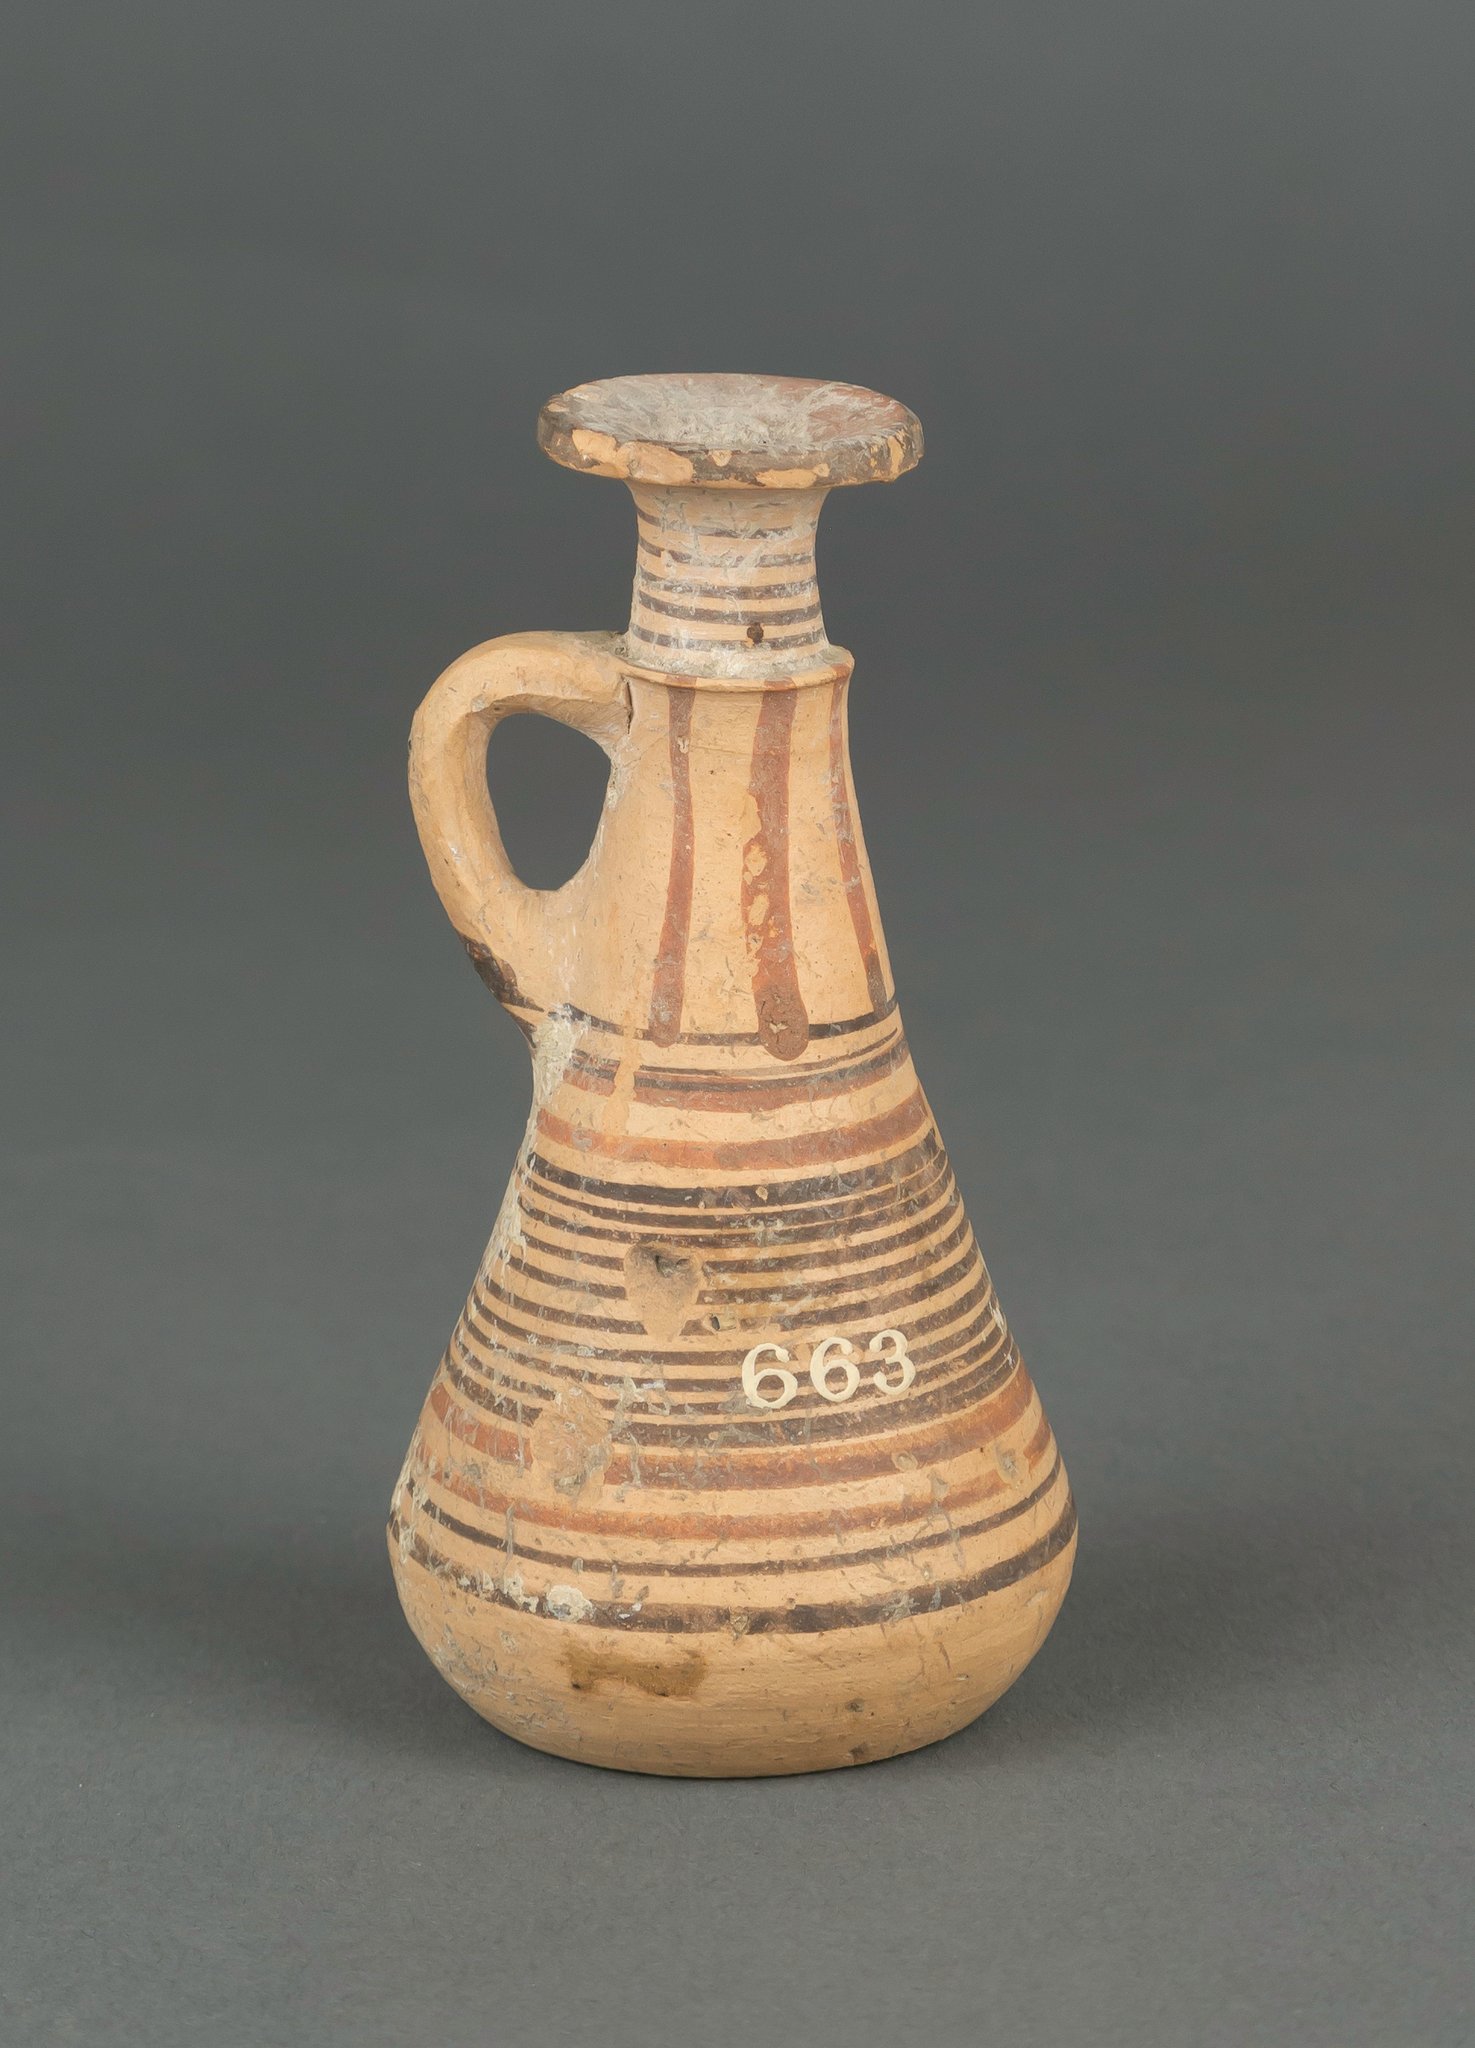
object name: juglet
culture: cypriot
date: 750-600 BCE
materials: terracotta